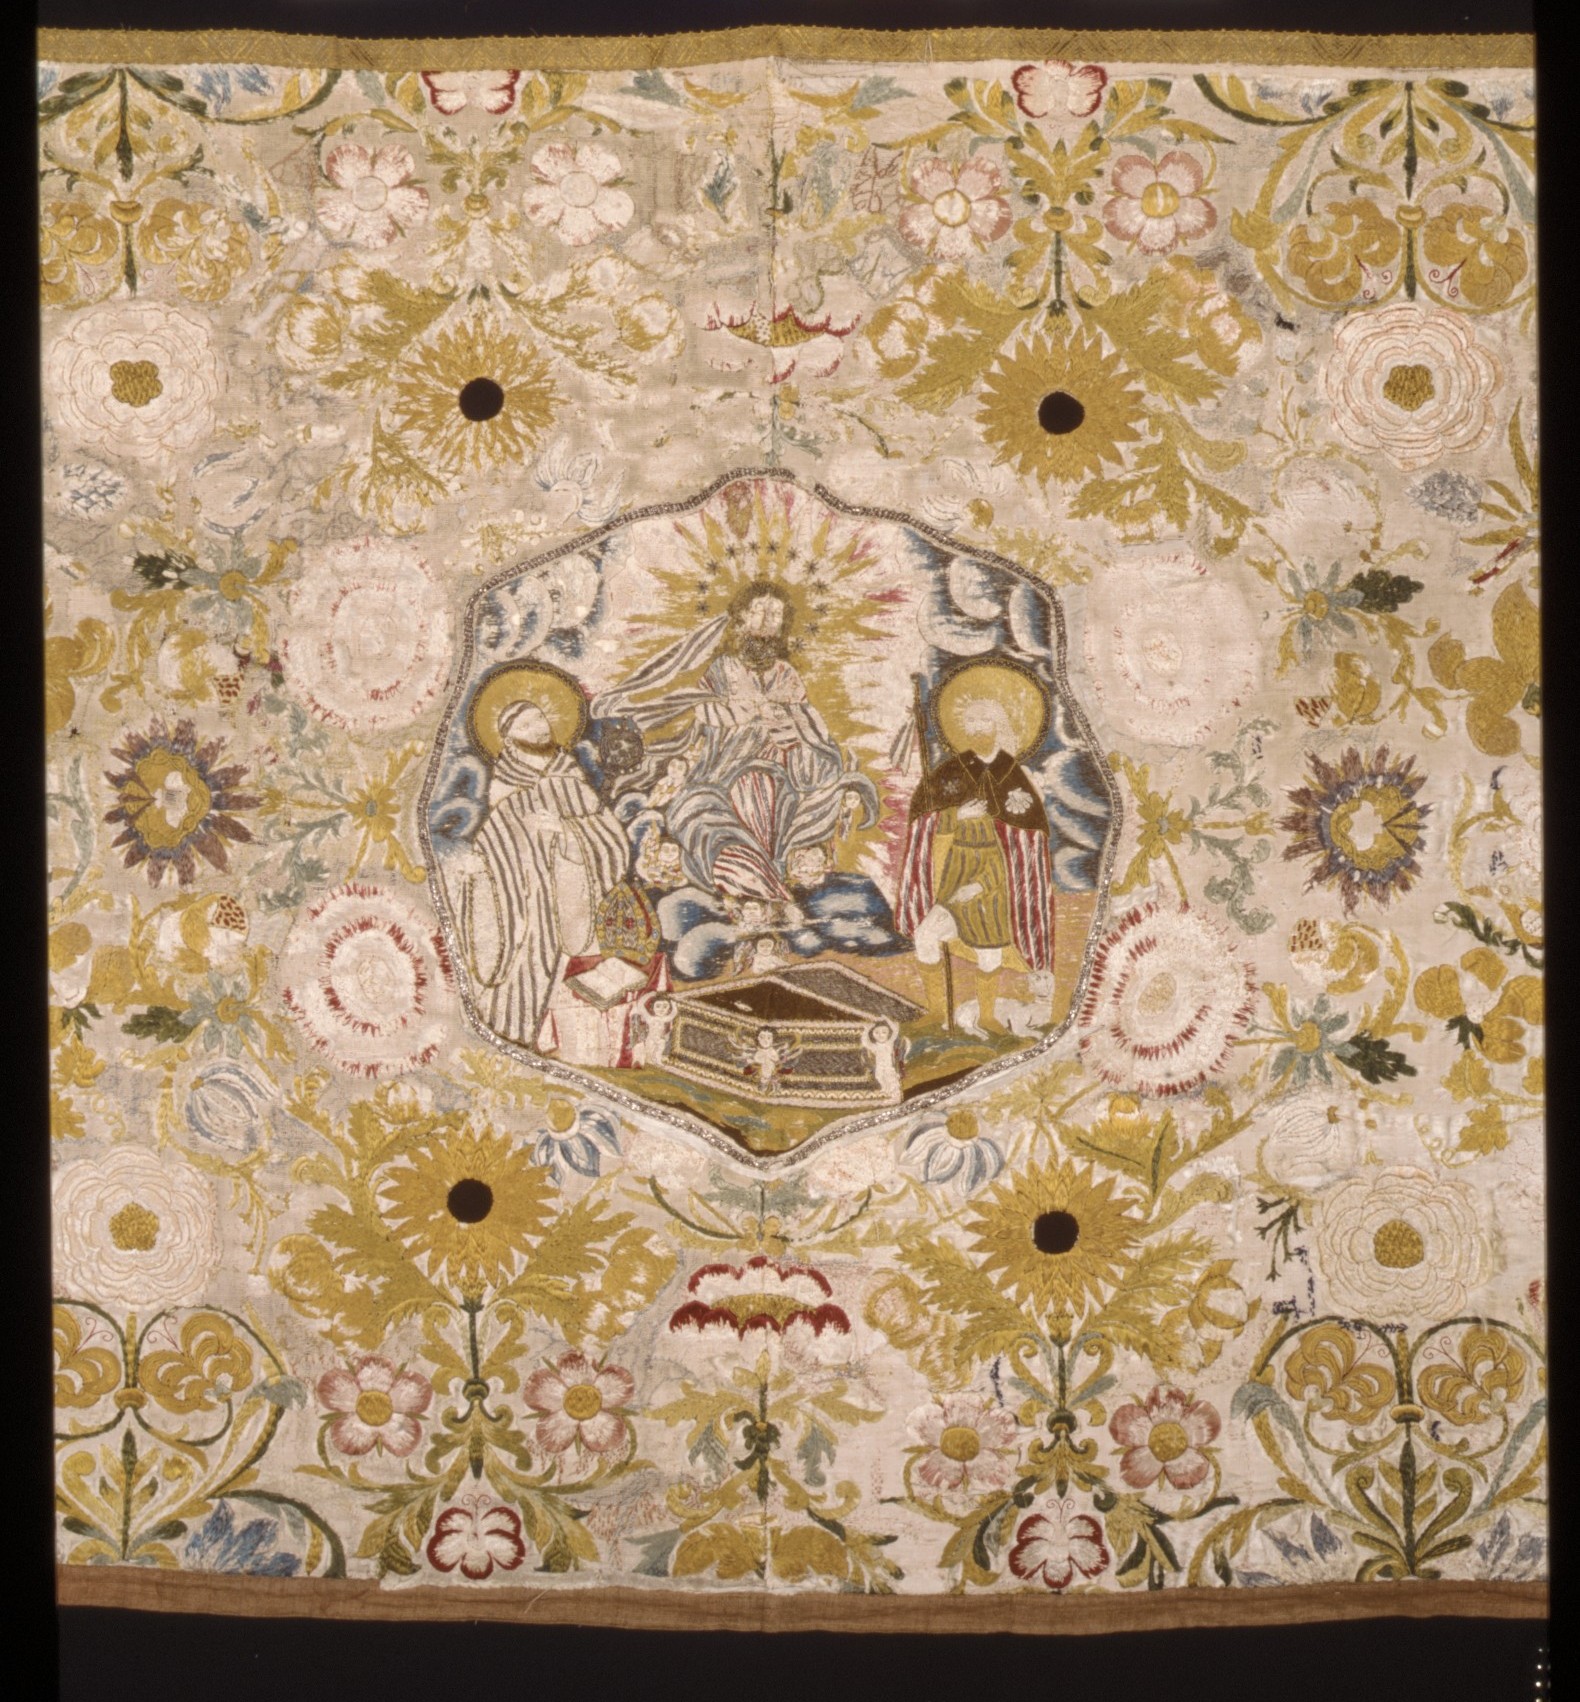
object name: antependium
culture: portuguese or spanish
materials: linen, metal, silk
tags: flowers,christ,saints